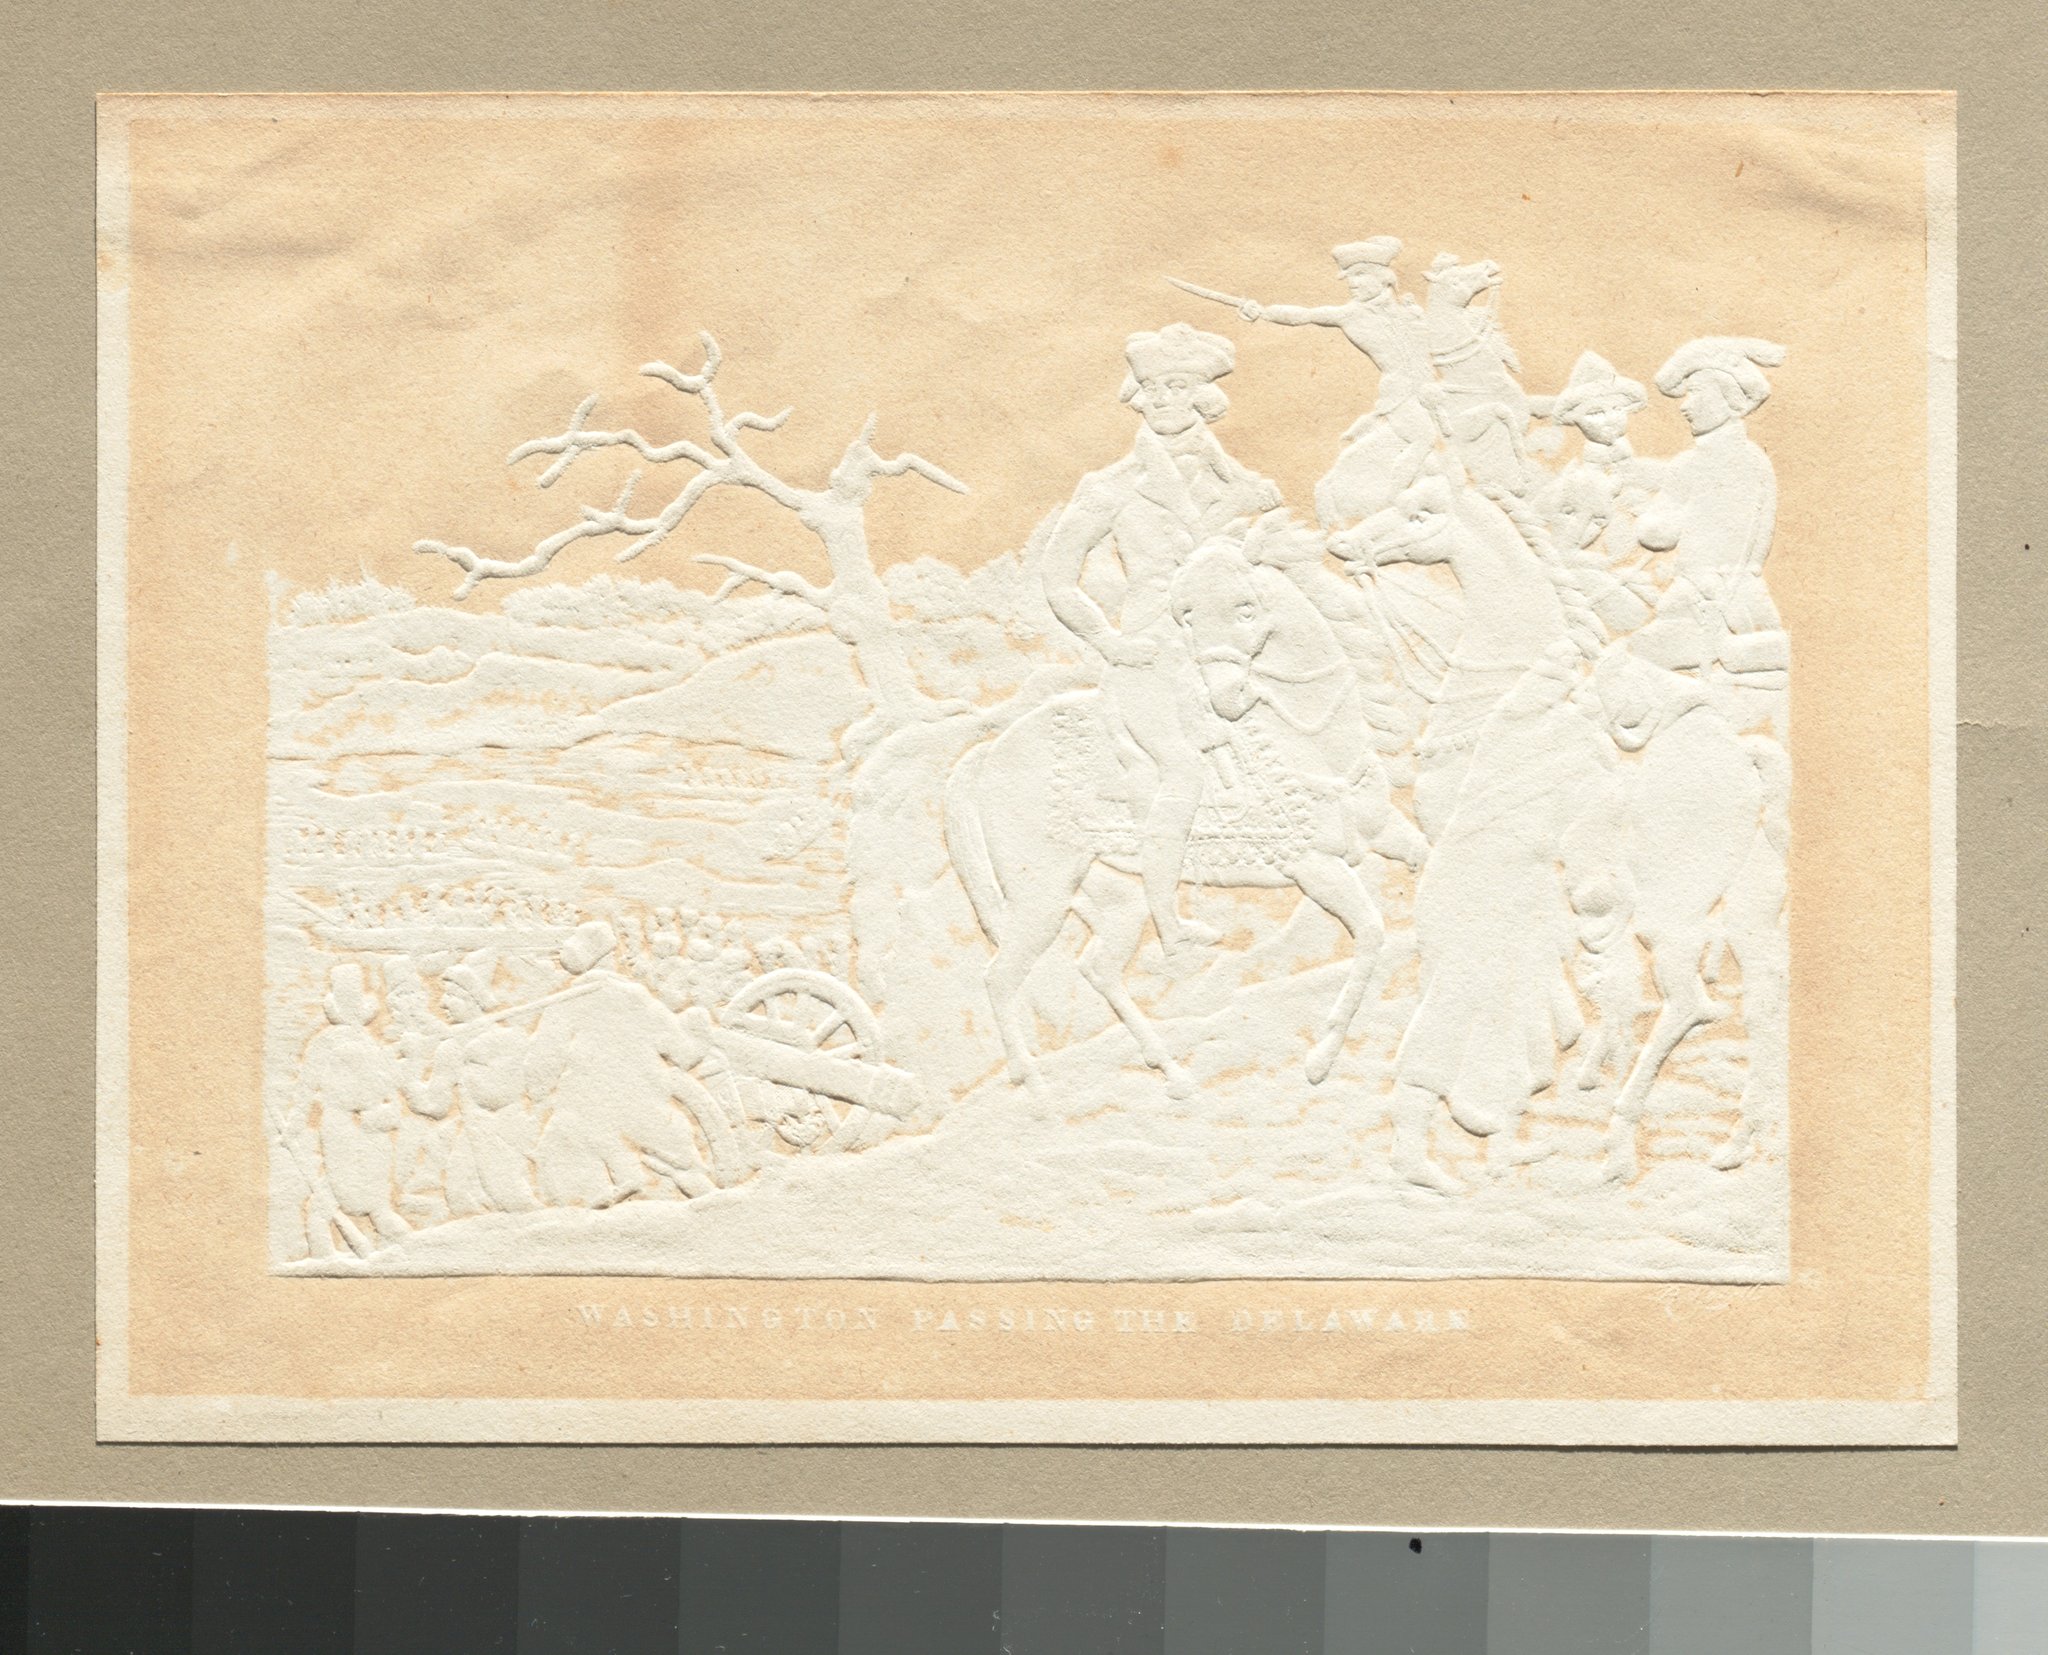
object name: cut paper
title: Washington Crossing the Delaware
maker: robert lovett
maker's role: artist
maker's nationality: american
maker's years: 1800-1830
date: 1701-1900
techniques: embossing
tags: battles,soldiers,cannons,george washington,horses